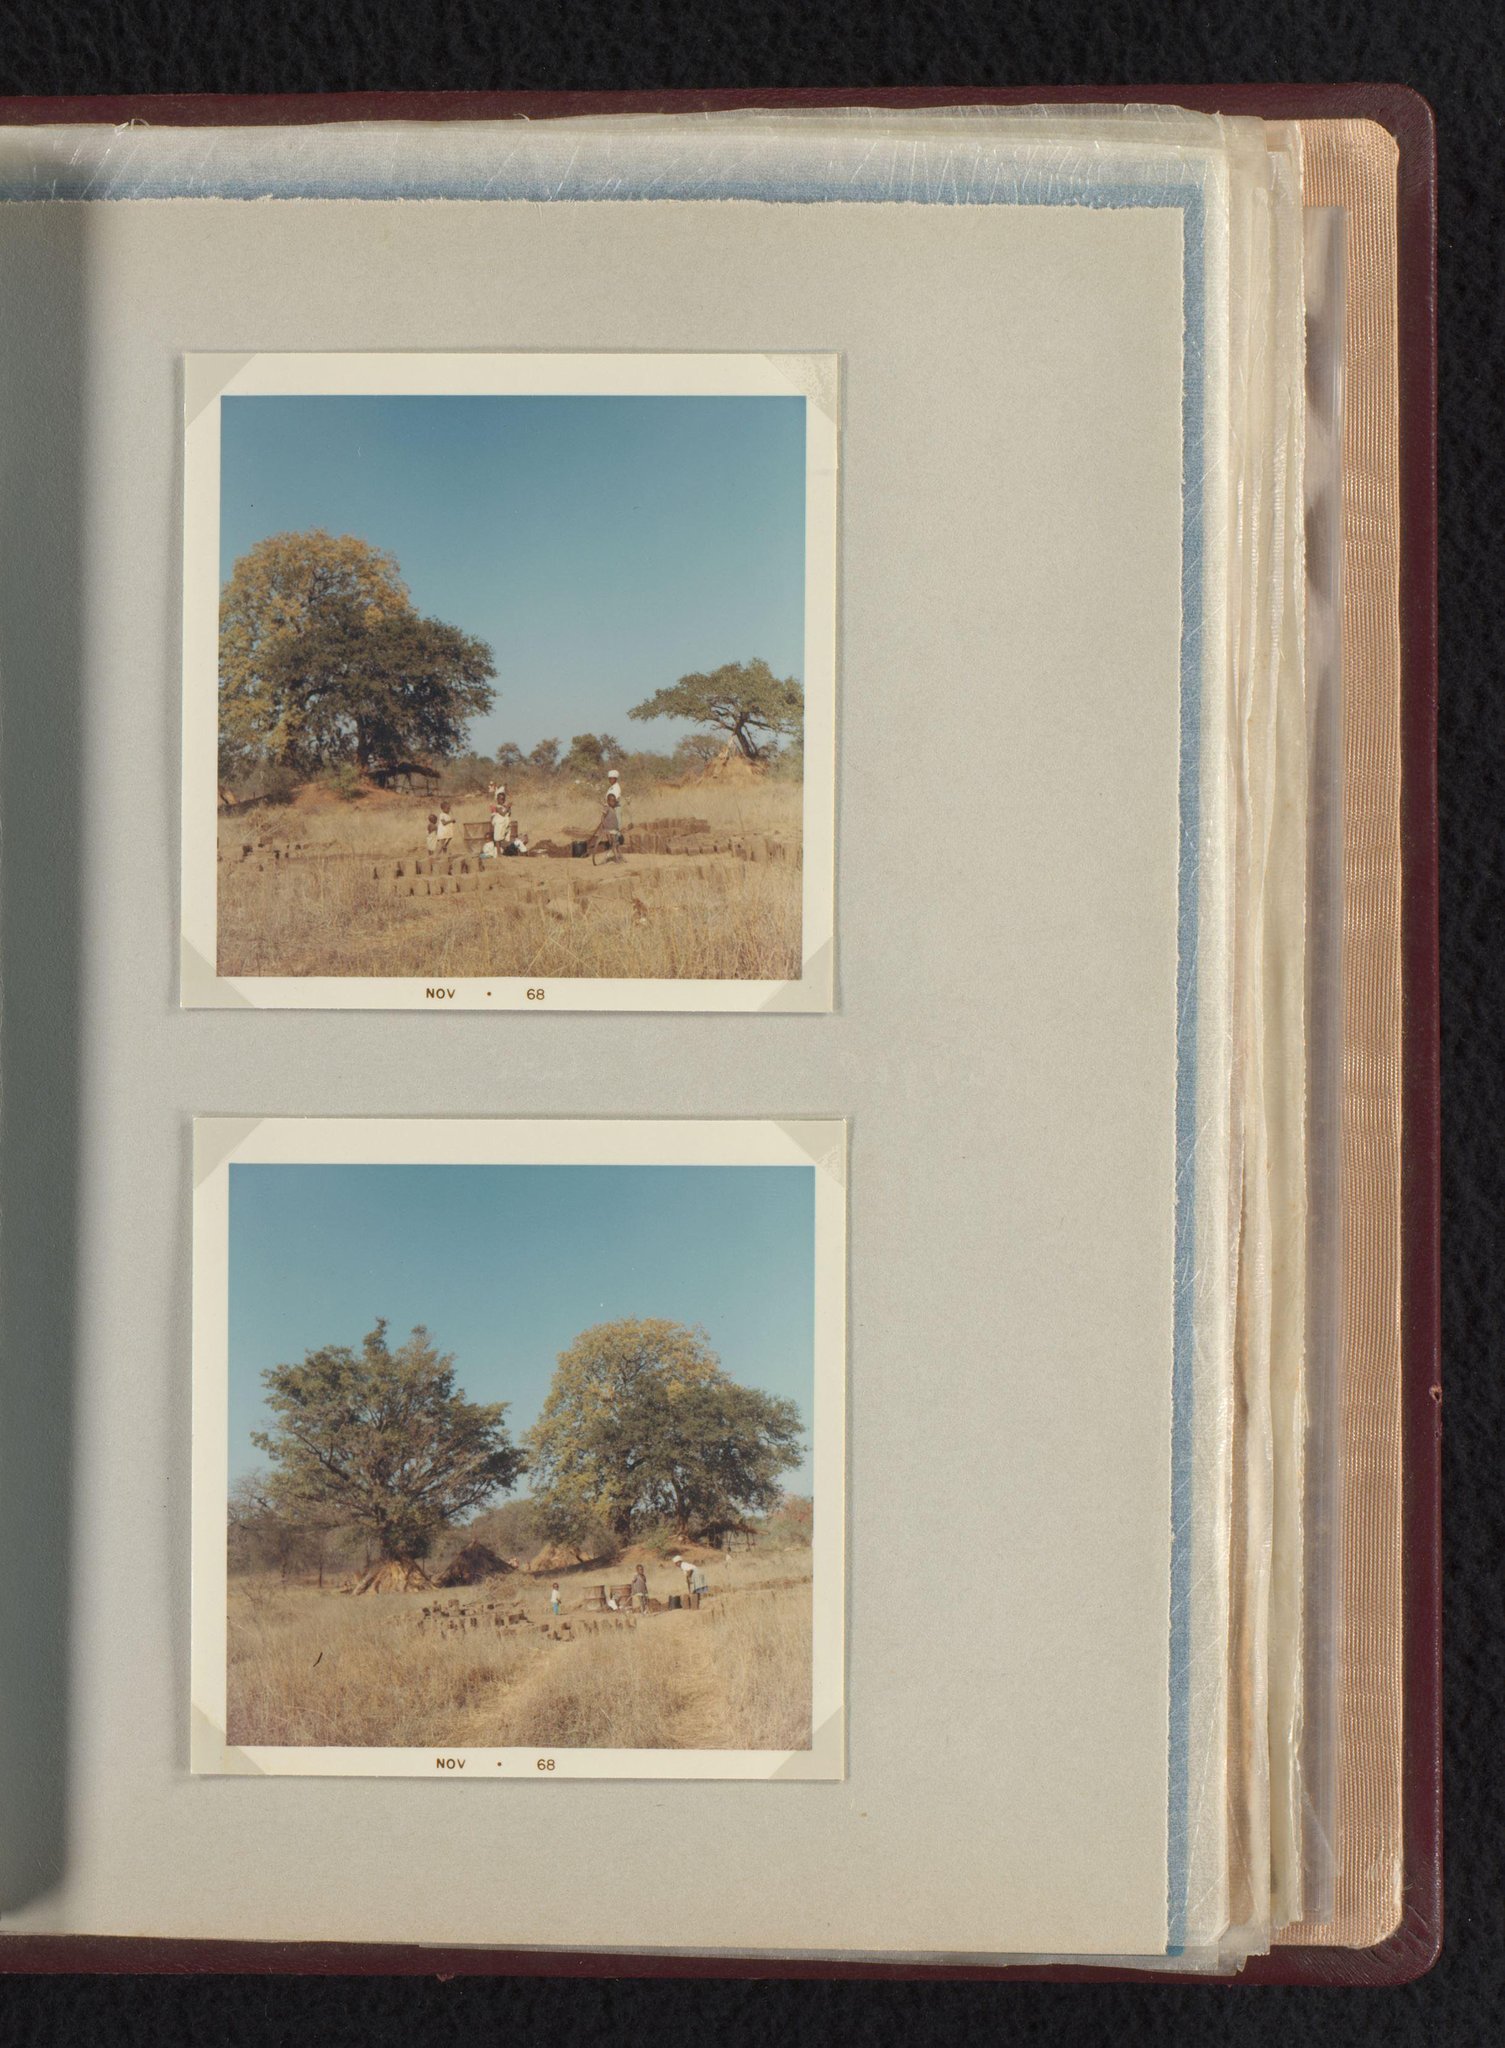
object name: album leaf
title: Zuid-Afrikaanse mensen bewerken een stuk grond bij Shewasaulu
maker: willem jacob van den berg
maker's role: boer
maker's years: 1902-1983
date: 1911-1968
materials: paper, cardboard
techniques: chromogenic print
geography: shewasaulu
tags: soil cultivation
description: Deze foto's zijn onderdeel van een album.